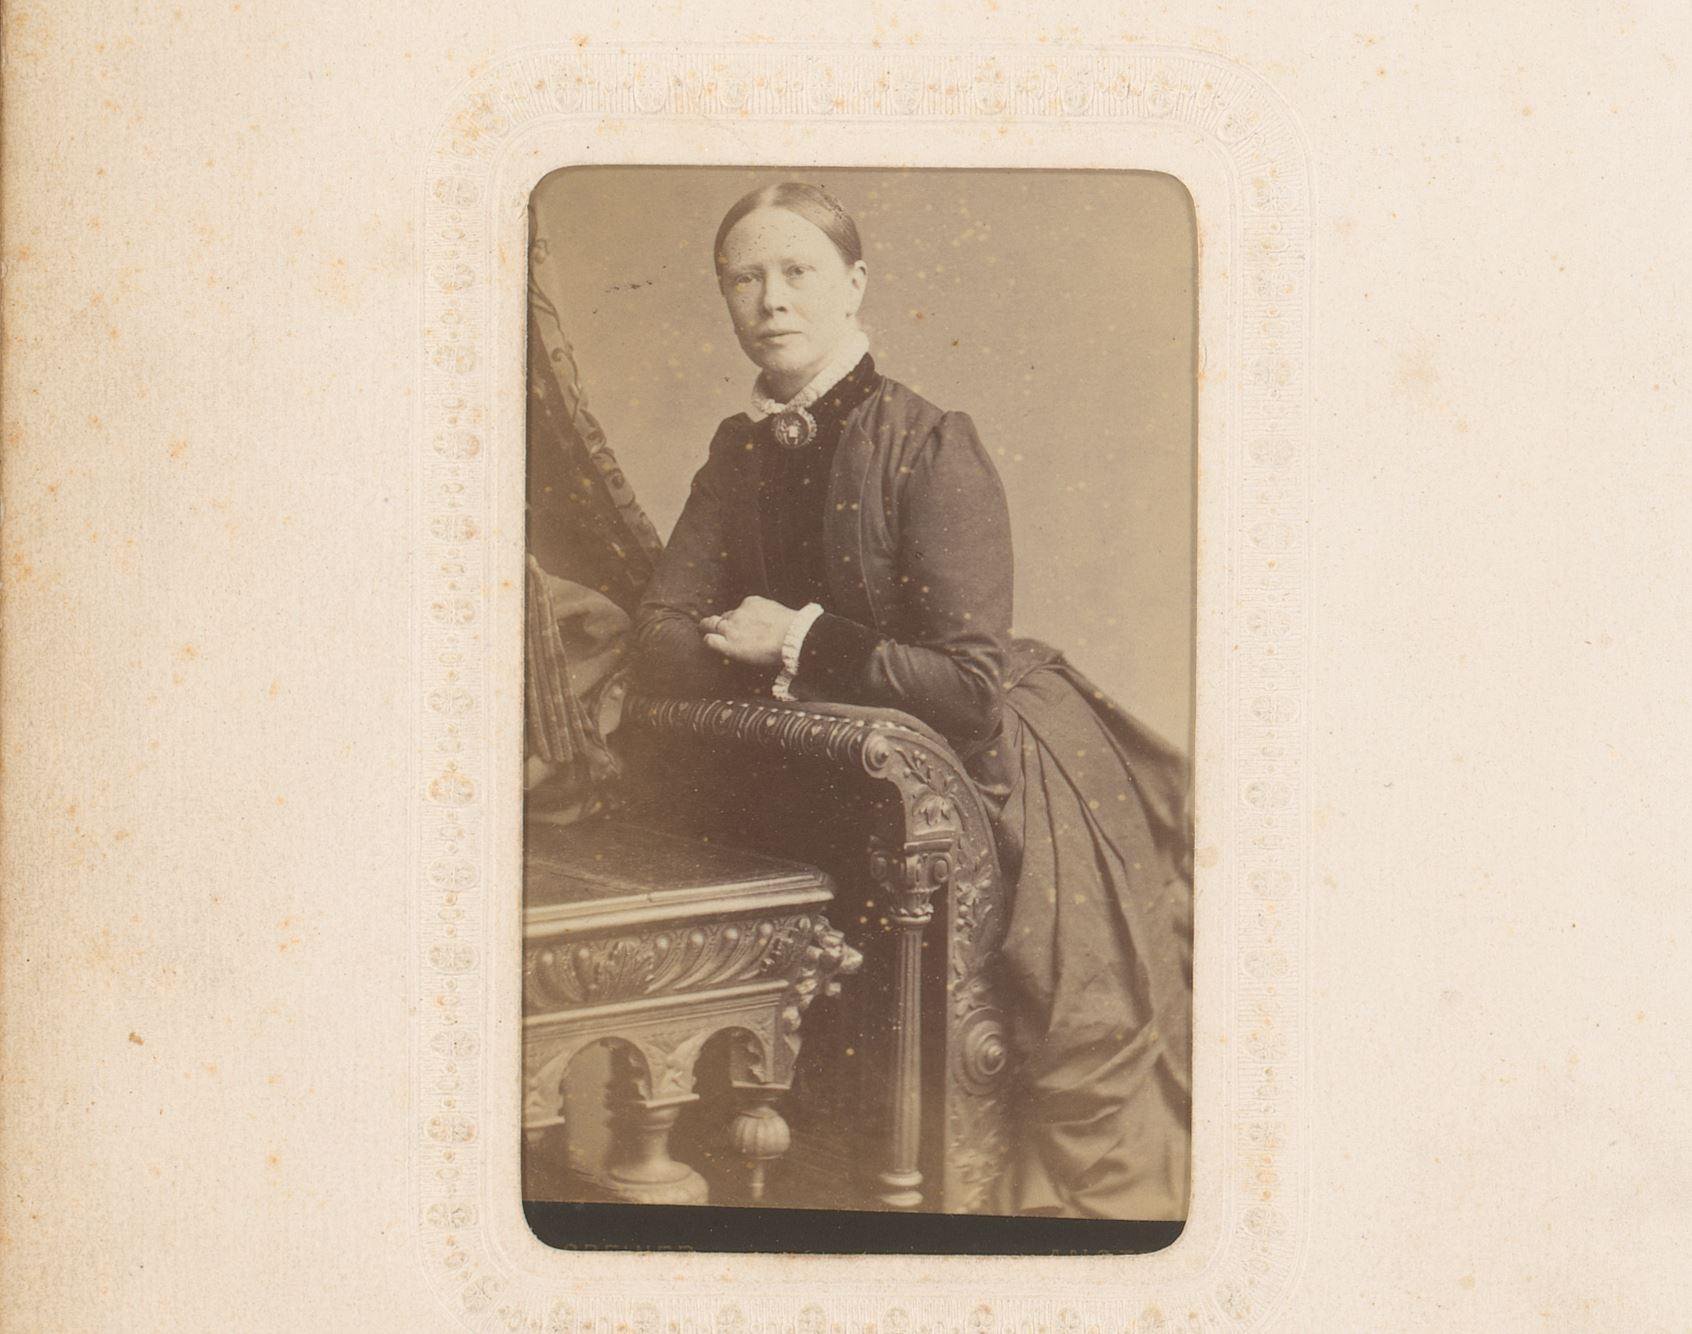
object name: carte de visite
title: Portret van Wies Meyer, leunend op een meubel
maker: Anonymous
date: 1860-1900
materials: cardboard, photographic support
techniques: albumen print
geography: netherlands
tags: adolescent, young woman, maiden, historical persons - bb - woman, standing figure - aa - female human figure, furniture and household effects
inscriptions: name: ‘Tante Wies Meyer’